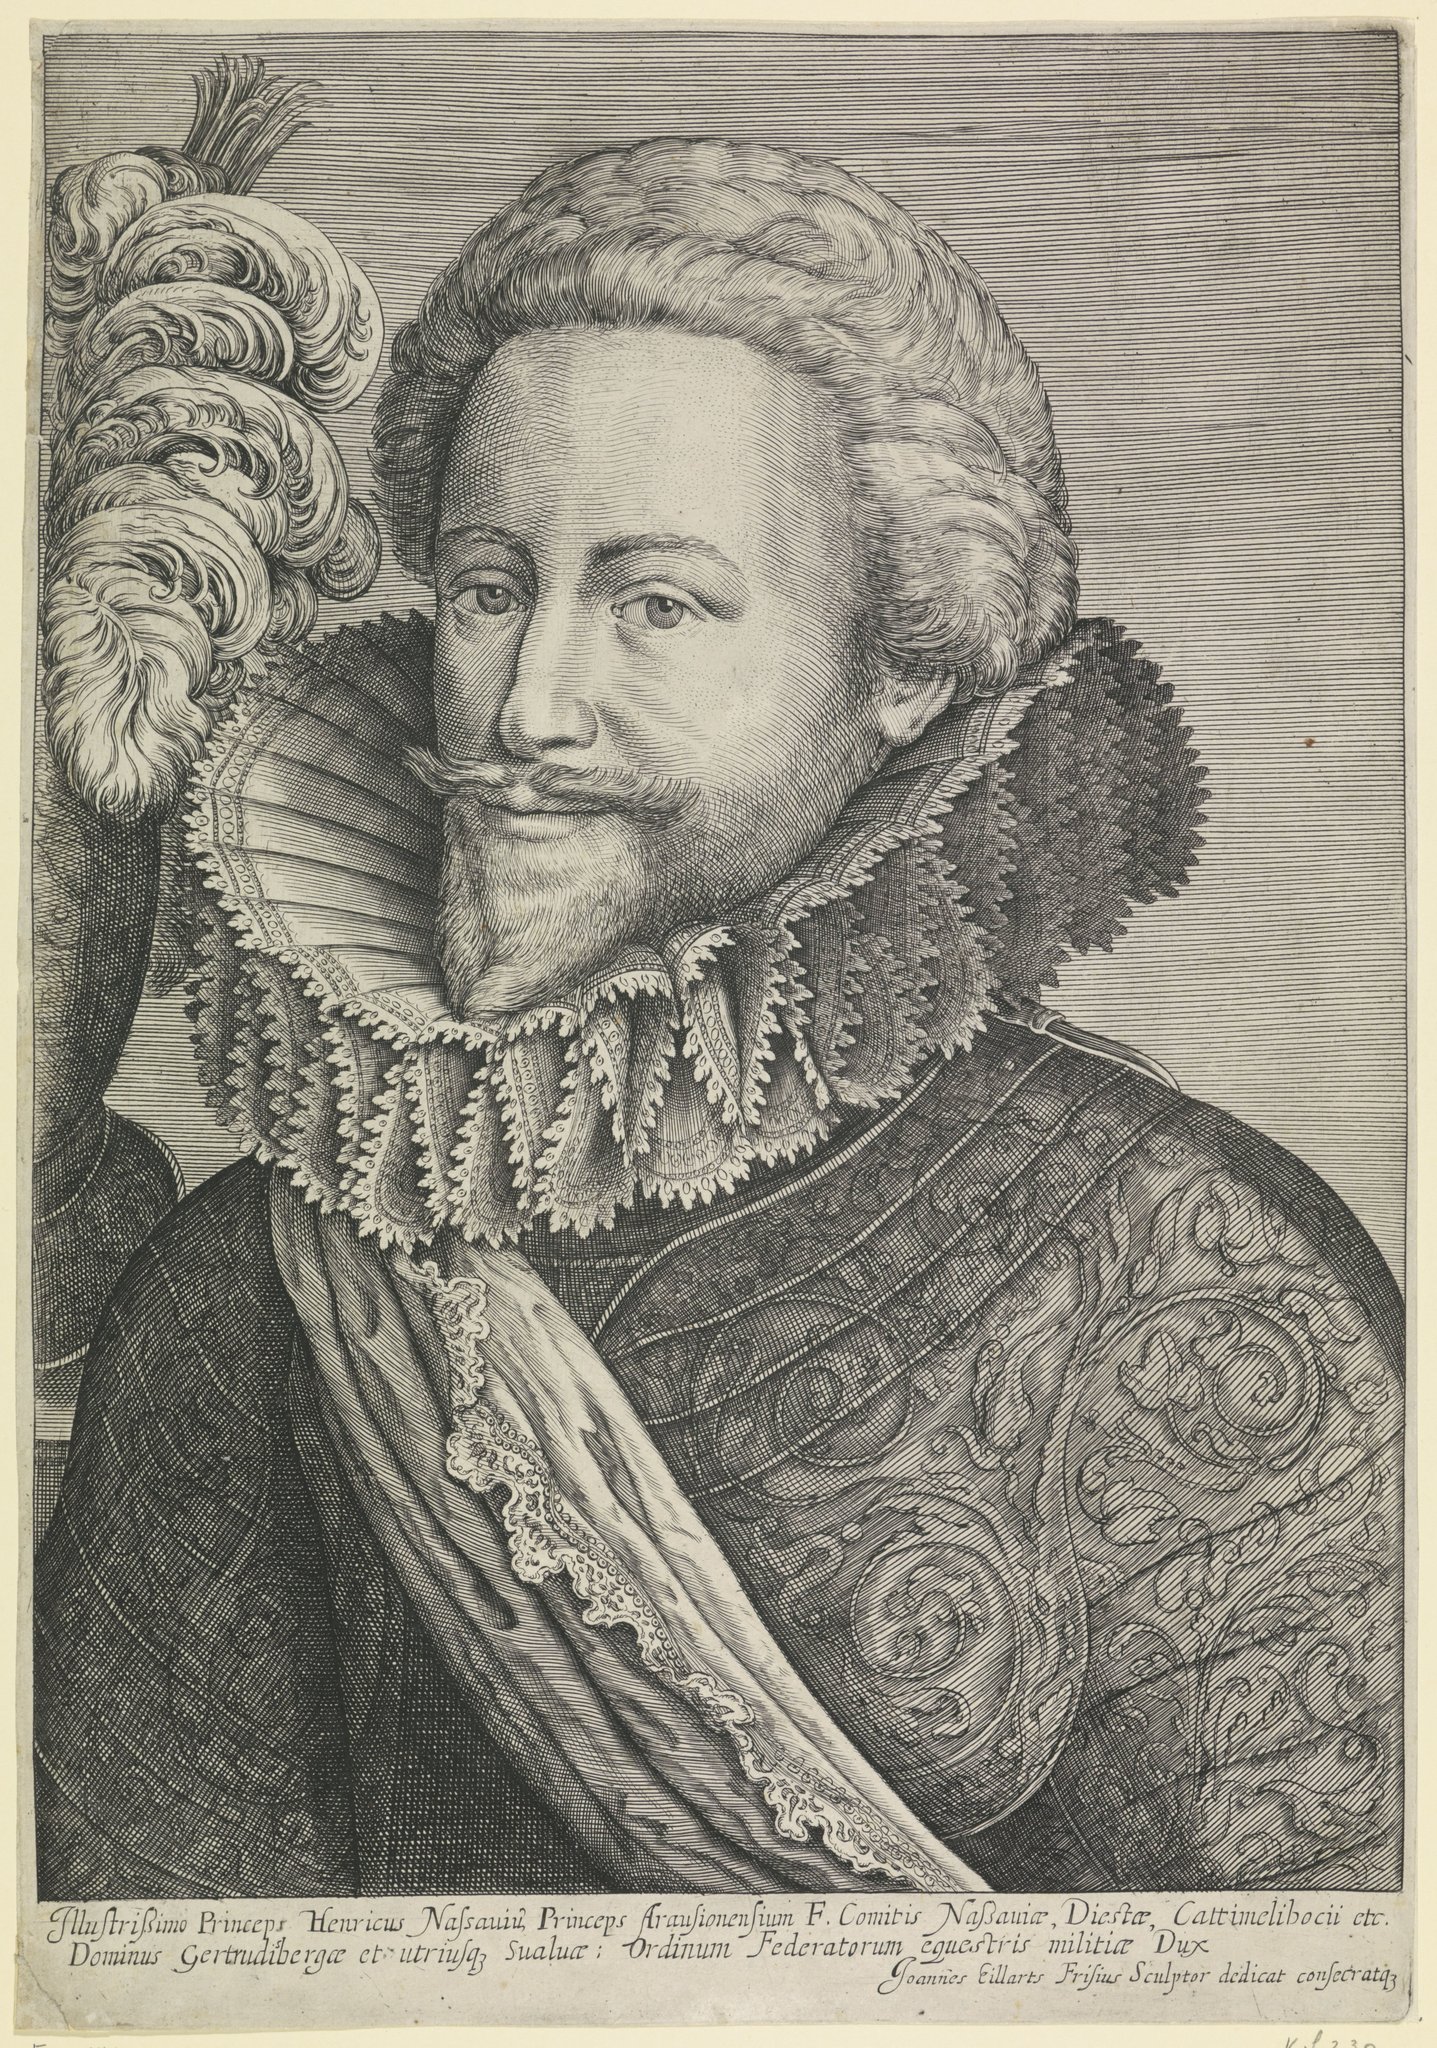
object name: print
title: Portret van Frederik Hendrik, prins van Oranje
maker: johannes eillarts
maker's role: print maker, publisher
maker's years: 1568-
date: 1600-1650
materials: paper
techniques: engraving, etching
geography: northern netherlands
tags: delft, the hague, frederick henry (prince of orange)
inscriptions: collector's mark: Lugt 963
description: De hier vermelde titel verwijst naar de hoogst verkregen titel van de geportretteerde, niet per se naar de titel die de geportretteerde op deze voorstelling draagt.